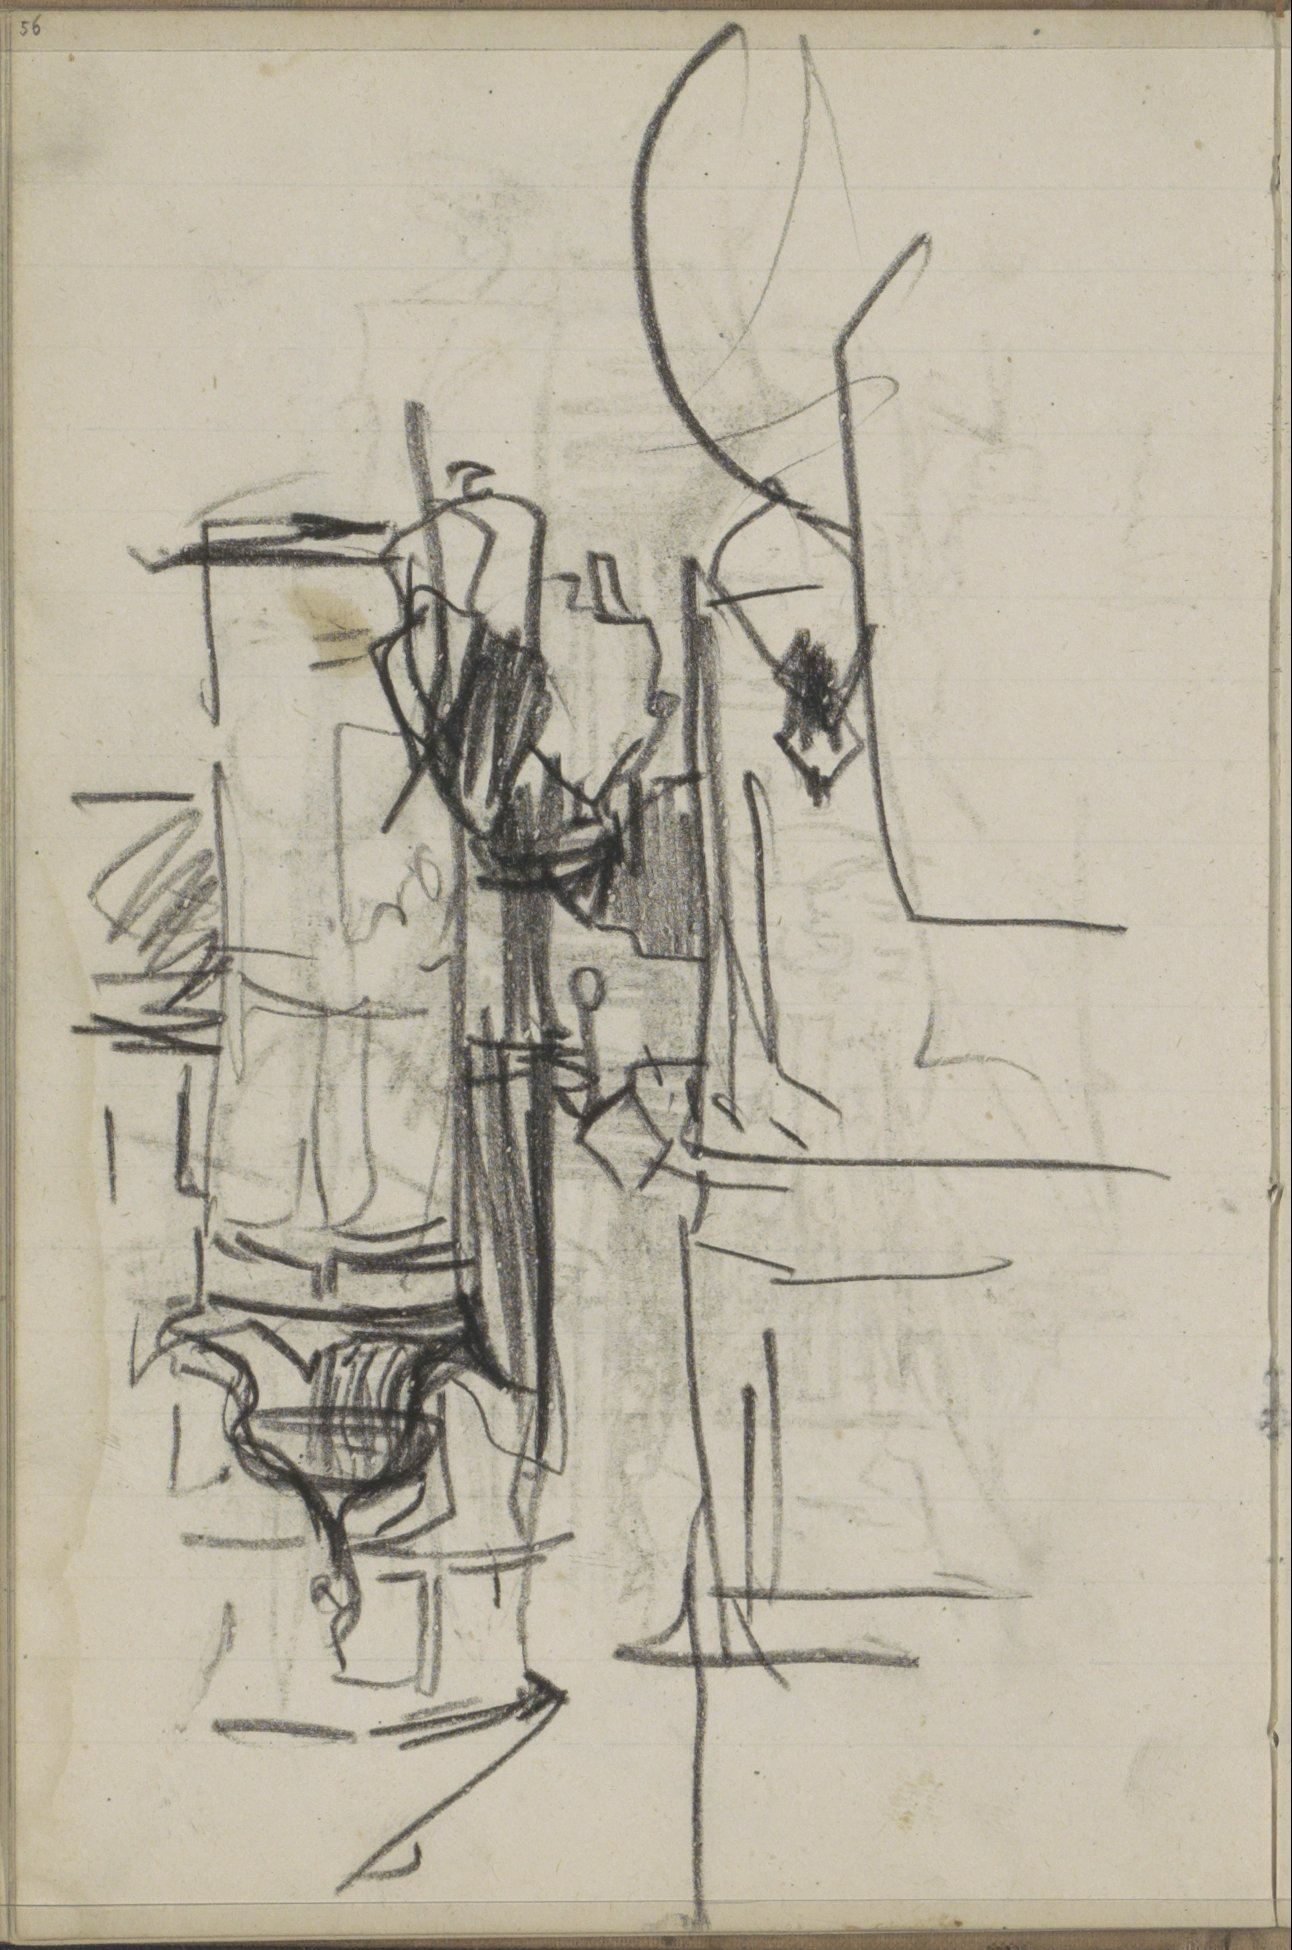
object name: sketchbook leaf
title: Straatgezicht met figuren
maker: marius bauer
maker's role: draughtsman, print maker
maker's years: 1867-1932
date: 1888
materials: chalk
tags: street (+ city(-scape) with figures, staffage)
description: Pagina 56 uit een schetsboek met 49 bladen.